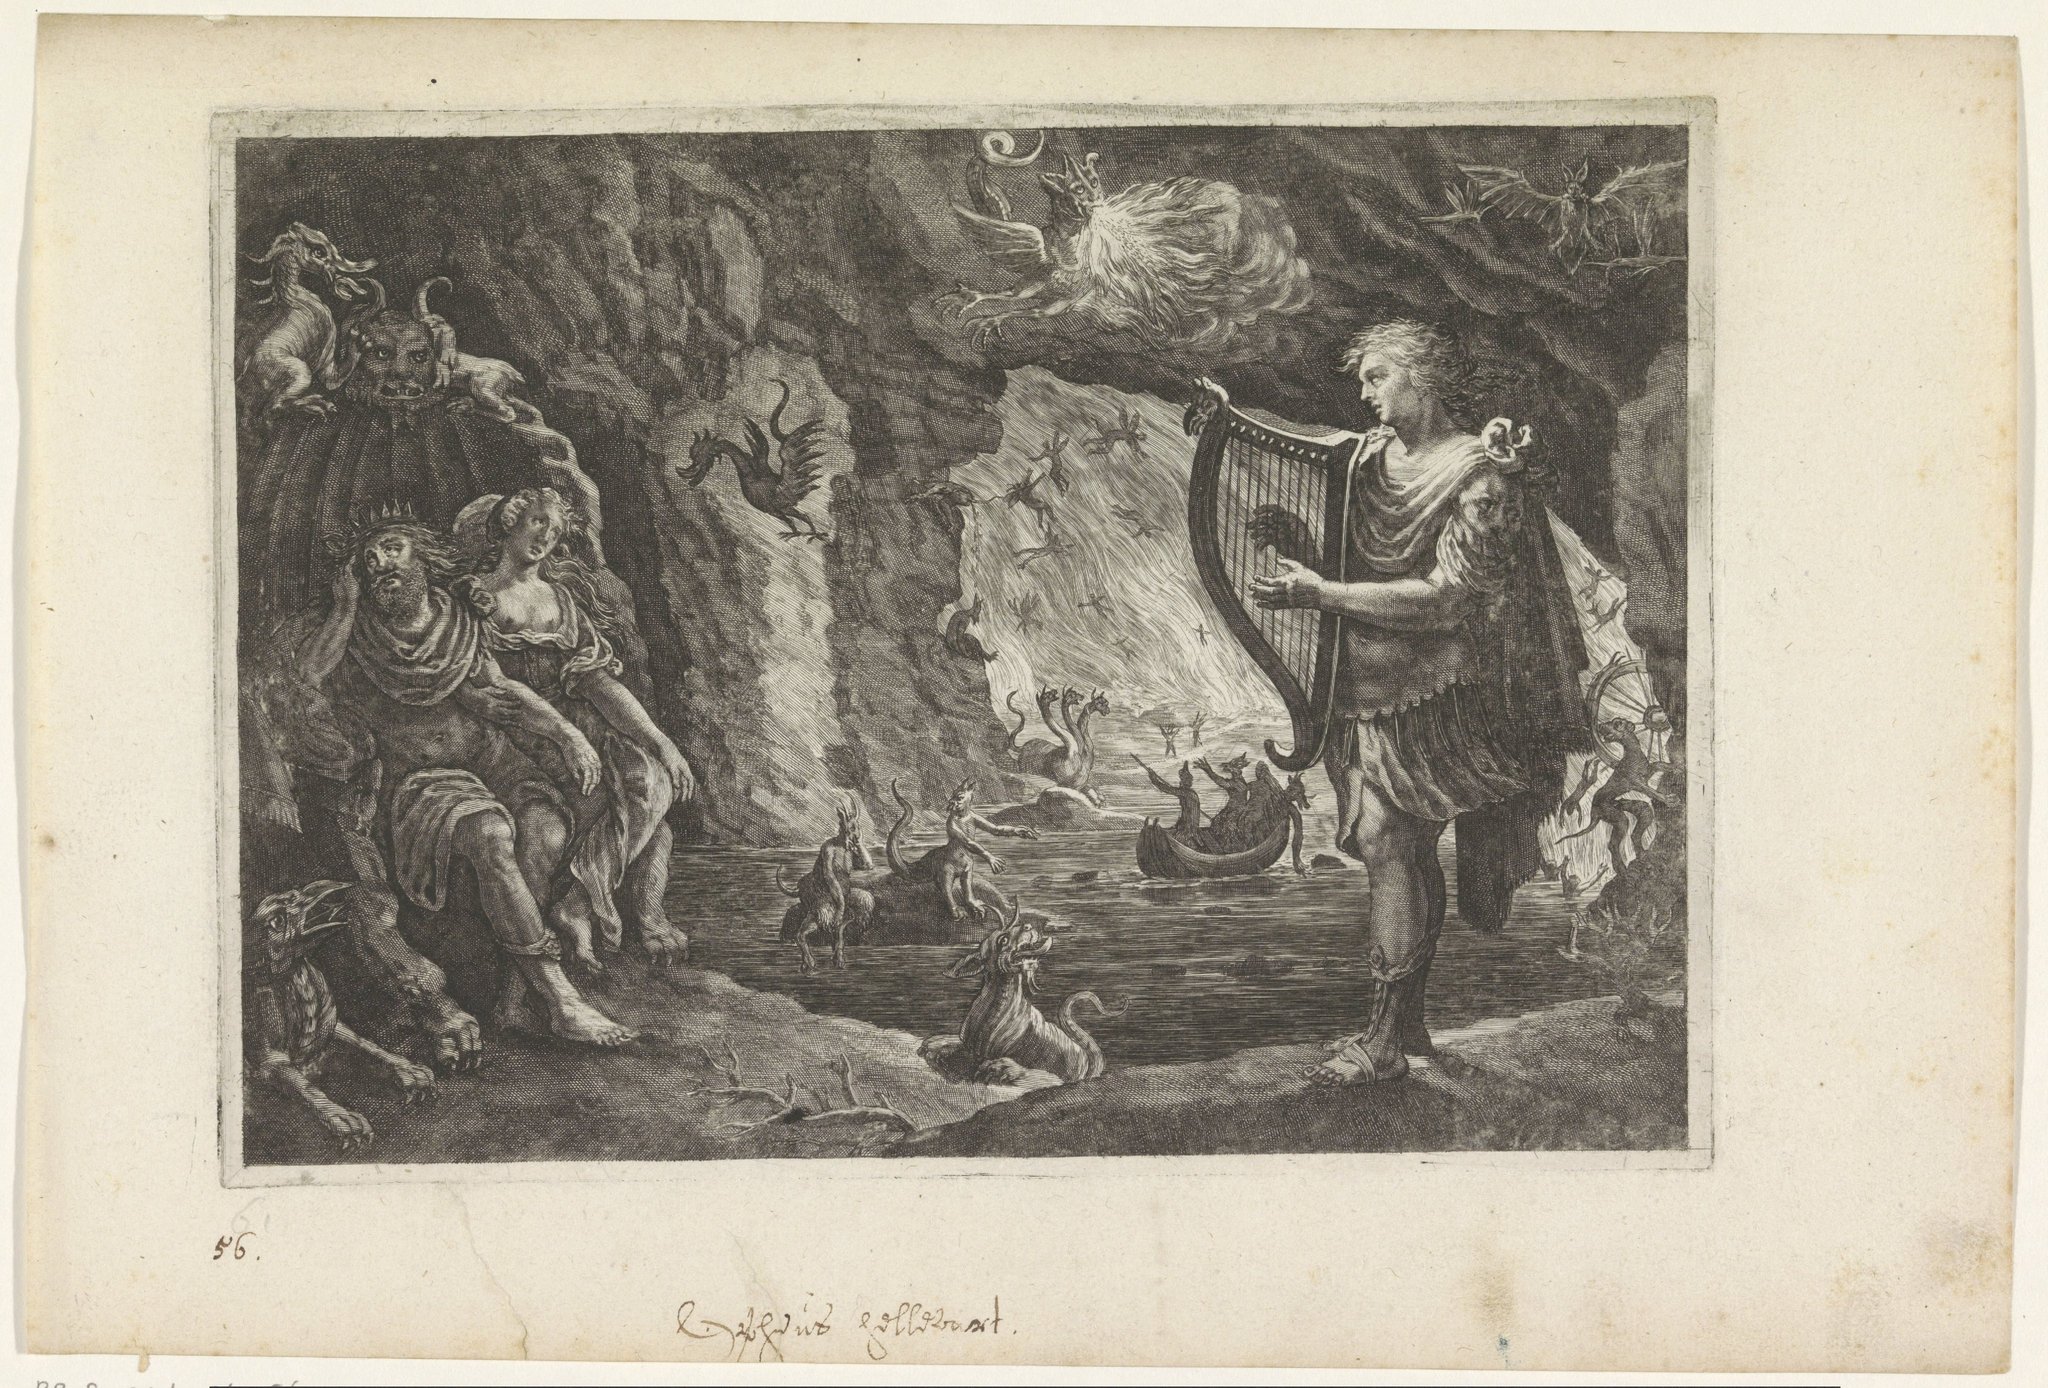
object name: print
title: Orpheus in the Underworld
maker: magdalena van de passe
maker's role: print maker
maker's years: 1600-1638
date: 1636-1670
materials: paper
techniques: engraving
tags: through his music orpheus induces pluto and/or proserpina to let eurydice go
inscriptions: number: ‘56’, collector's mark: ‘Hinloopen’, annotation: ‘Orpheus hellevaert.’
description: Magdalena de Passe set the story about the sculptor Pygmalion who fell in love with his own statue of a woman in the dark. Equally spectacular are the contrasts of light and dark in the scene in which the musician Orpheus persuades the god of the underworld to return his beloved Eurydice alive.